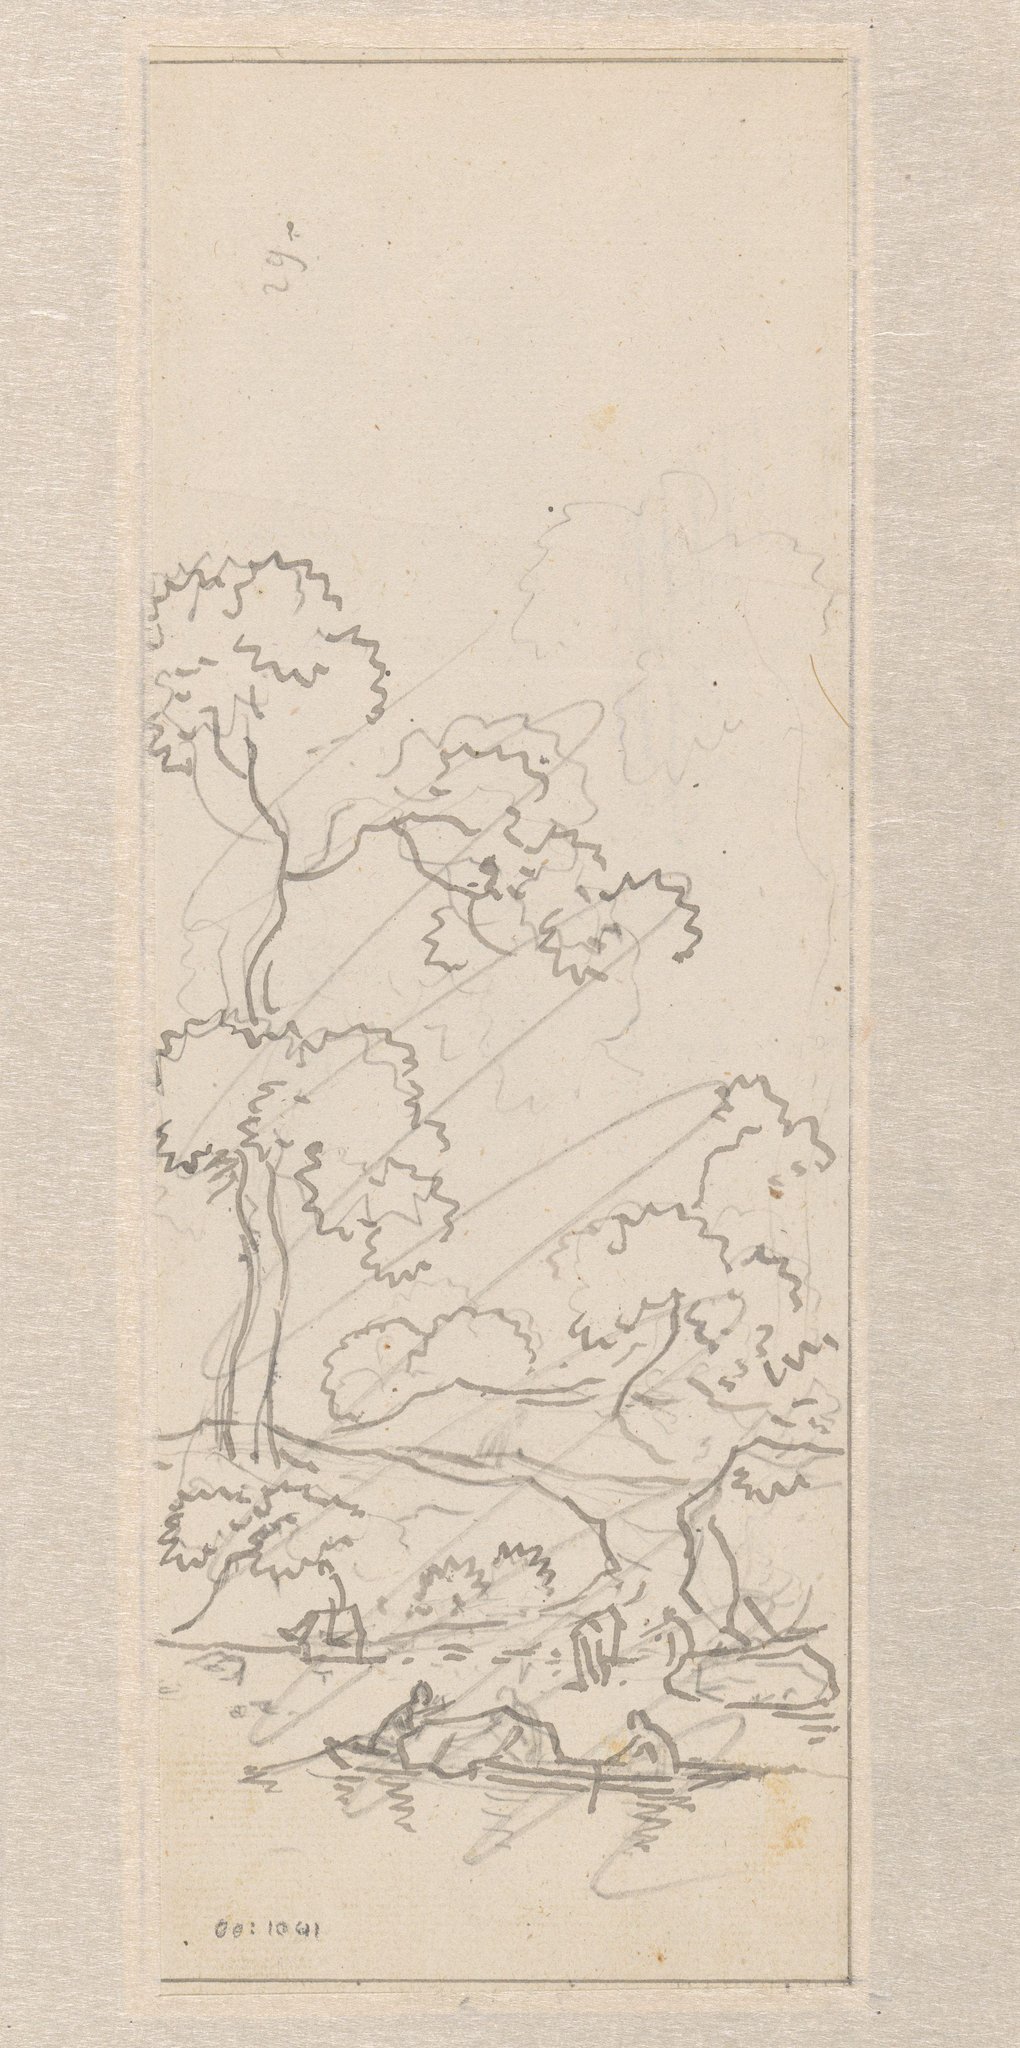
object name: design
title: Ontwerp voor behangselschildering met bootje bij rivieroever (doorgekrast)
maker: jurriaan andriessen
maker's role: draughtsman, painter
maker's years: 1742-1819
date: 1752-1819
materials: ink, paper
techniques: pen